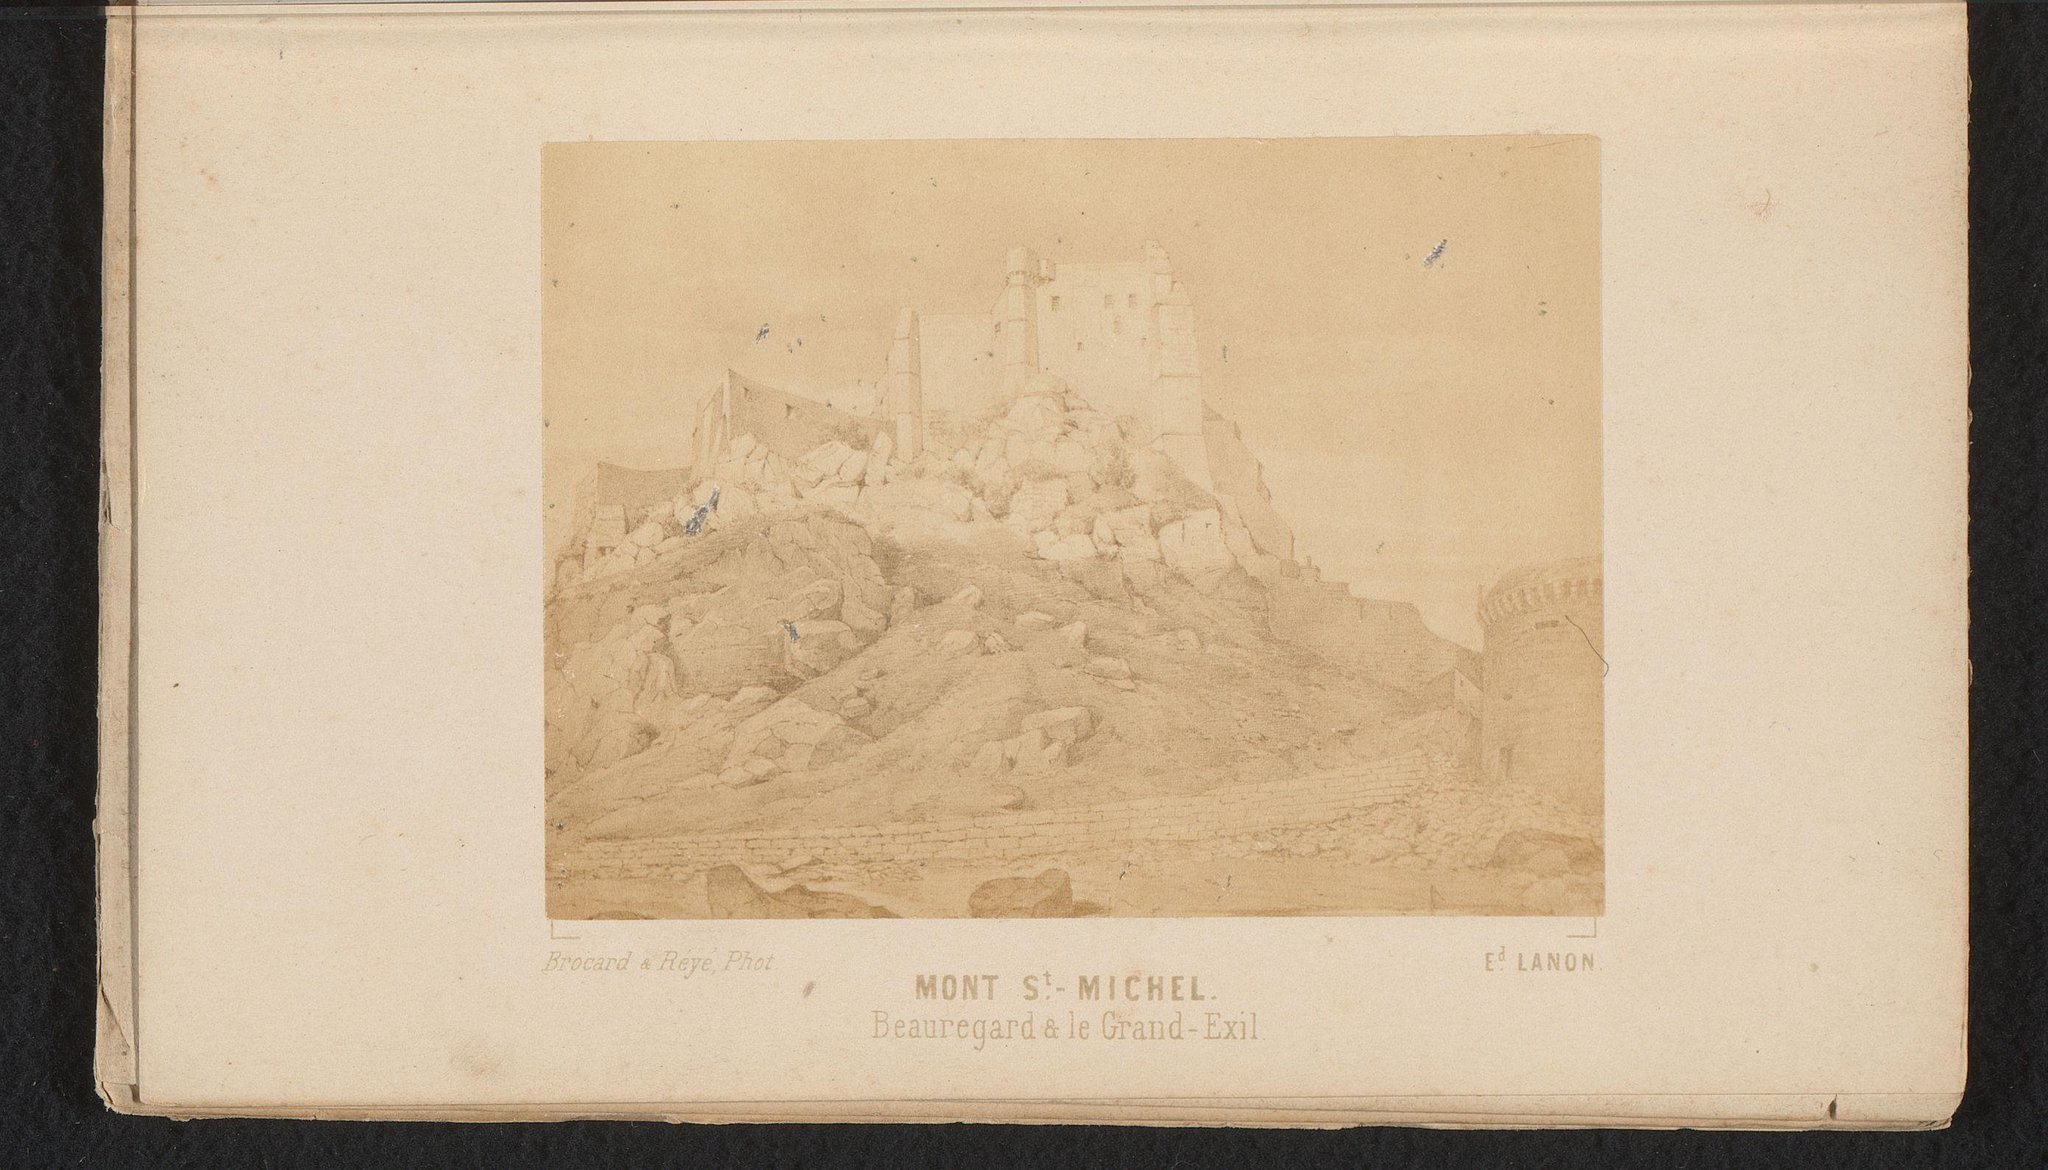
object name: reproduction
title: Mont St. Michel. Beauregard & le Grand-Exil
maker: edmond lanon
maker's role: designer, draughtsman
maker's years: 1830-1871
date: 1861-1866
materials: paper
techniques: albumen print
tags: abbey, monastery, convent ~ roman catholic church, walls ~ fortified city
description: Foto op ongenummerde pagina tegenover pagina 24.